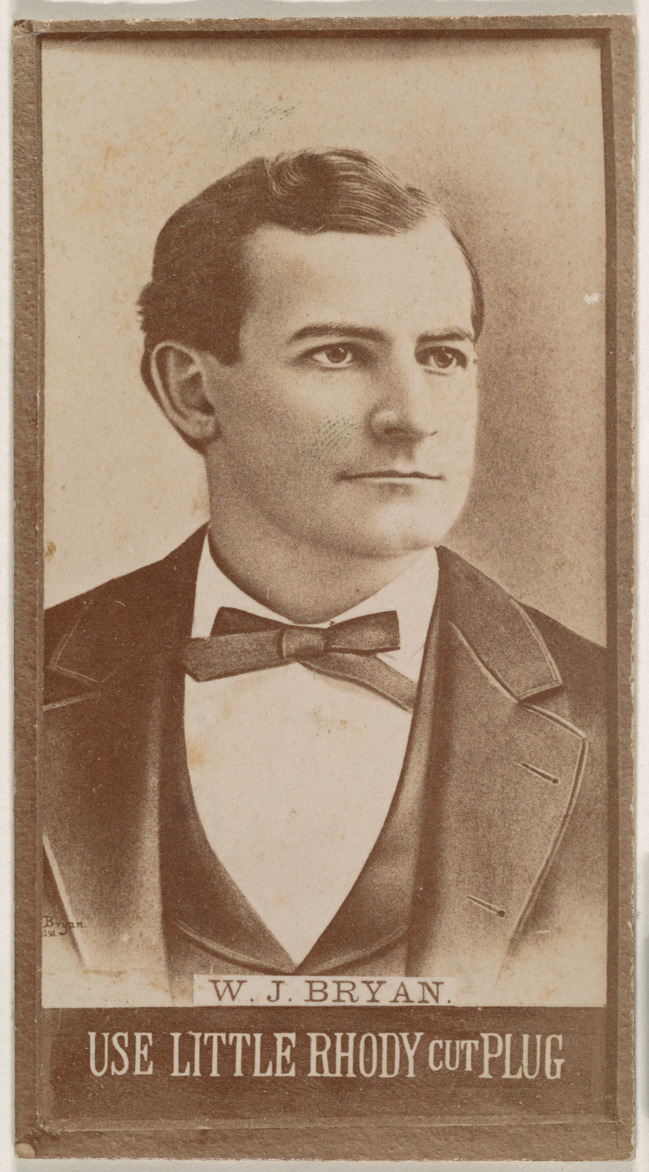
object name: photograph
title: W.J. Bryan, from the series N694, promoting Little Rhody Cut Plug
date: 1888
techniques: albumen silver print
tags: men,portraits